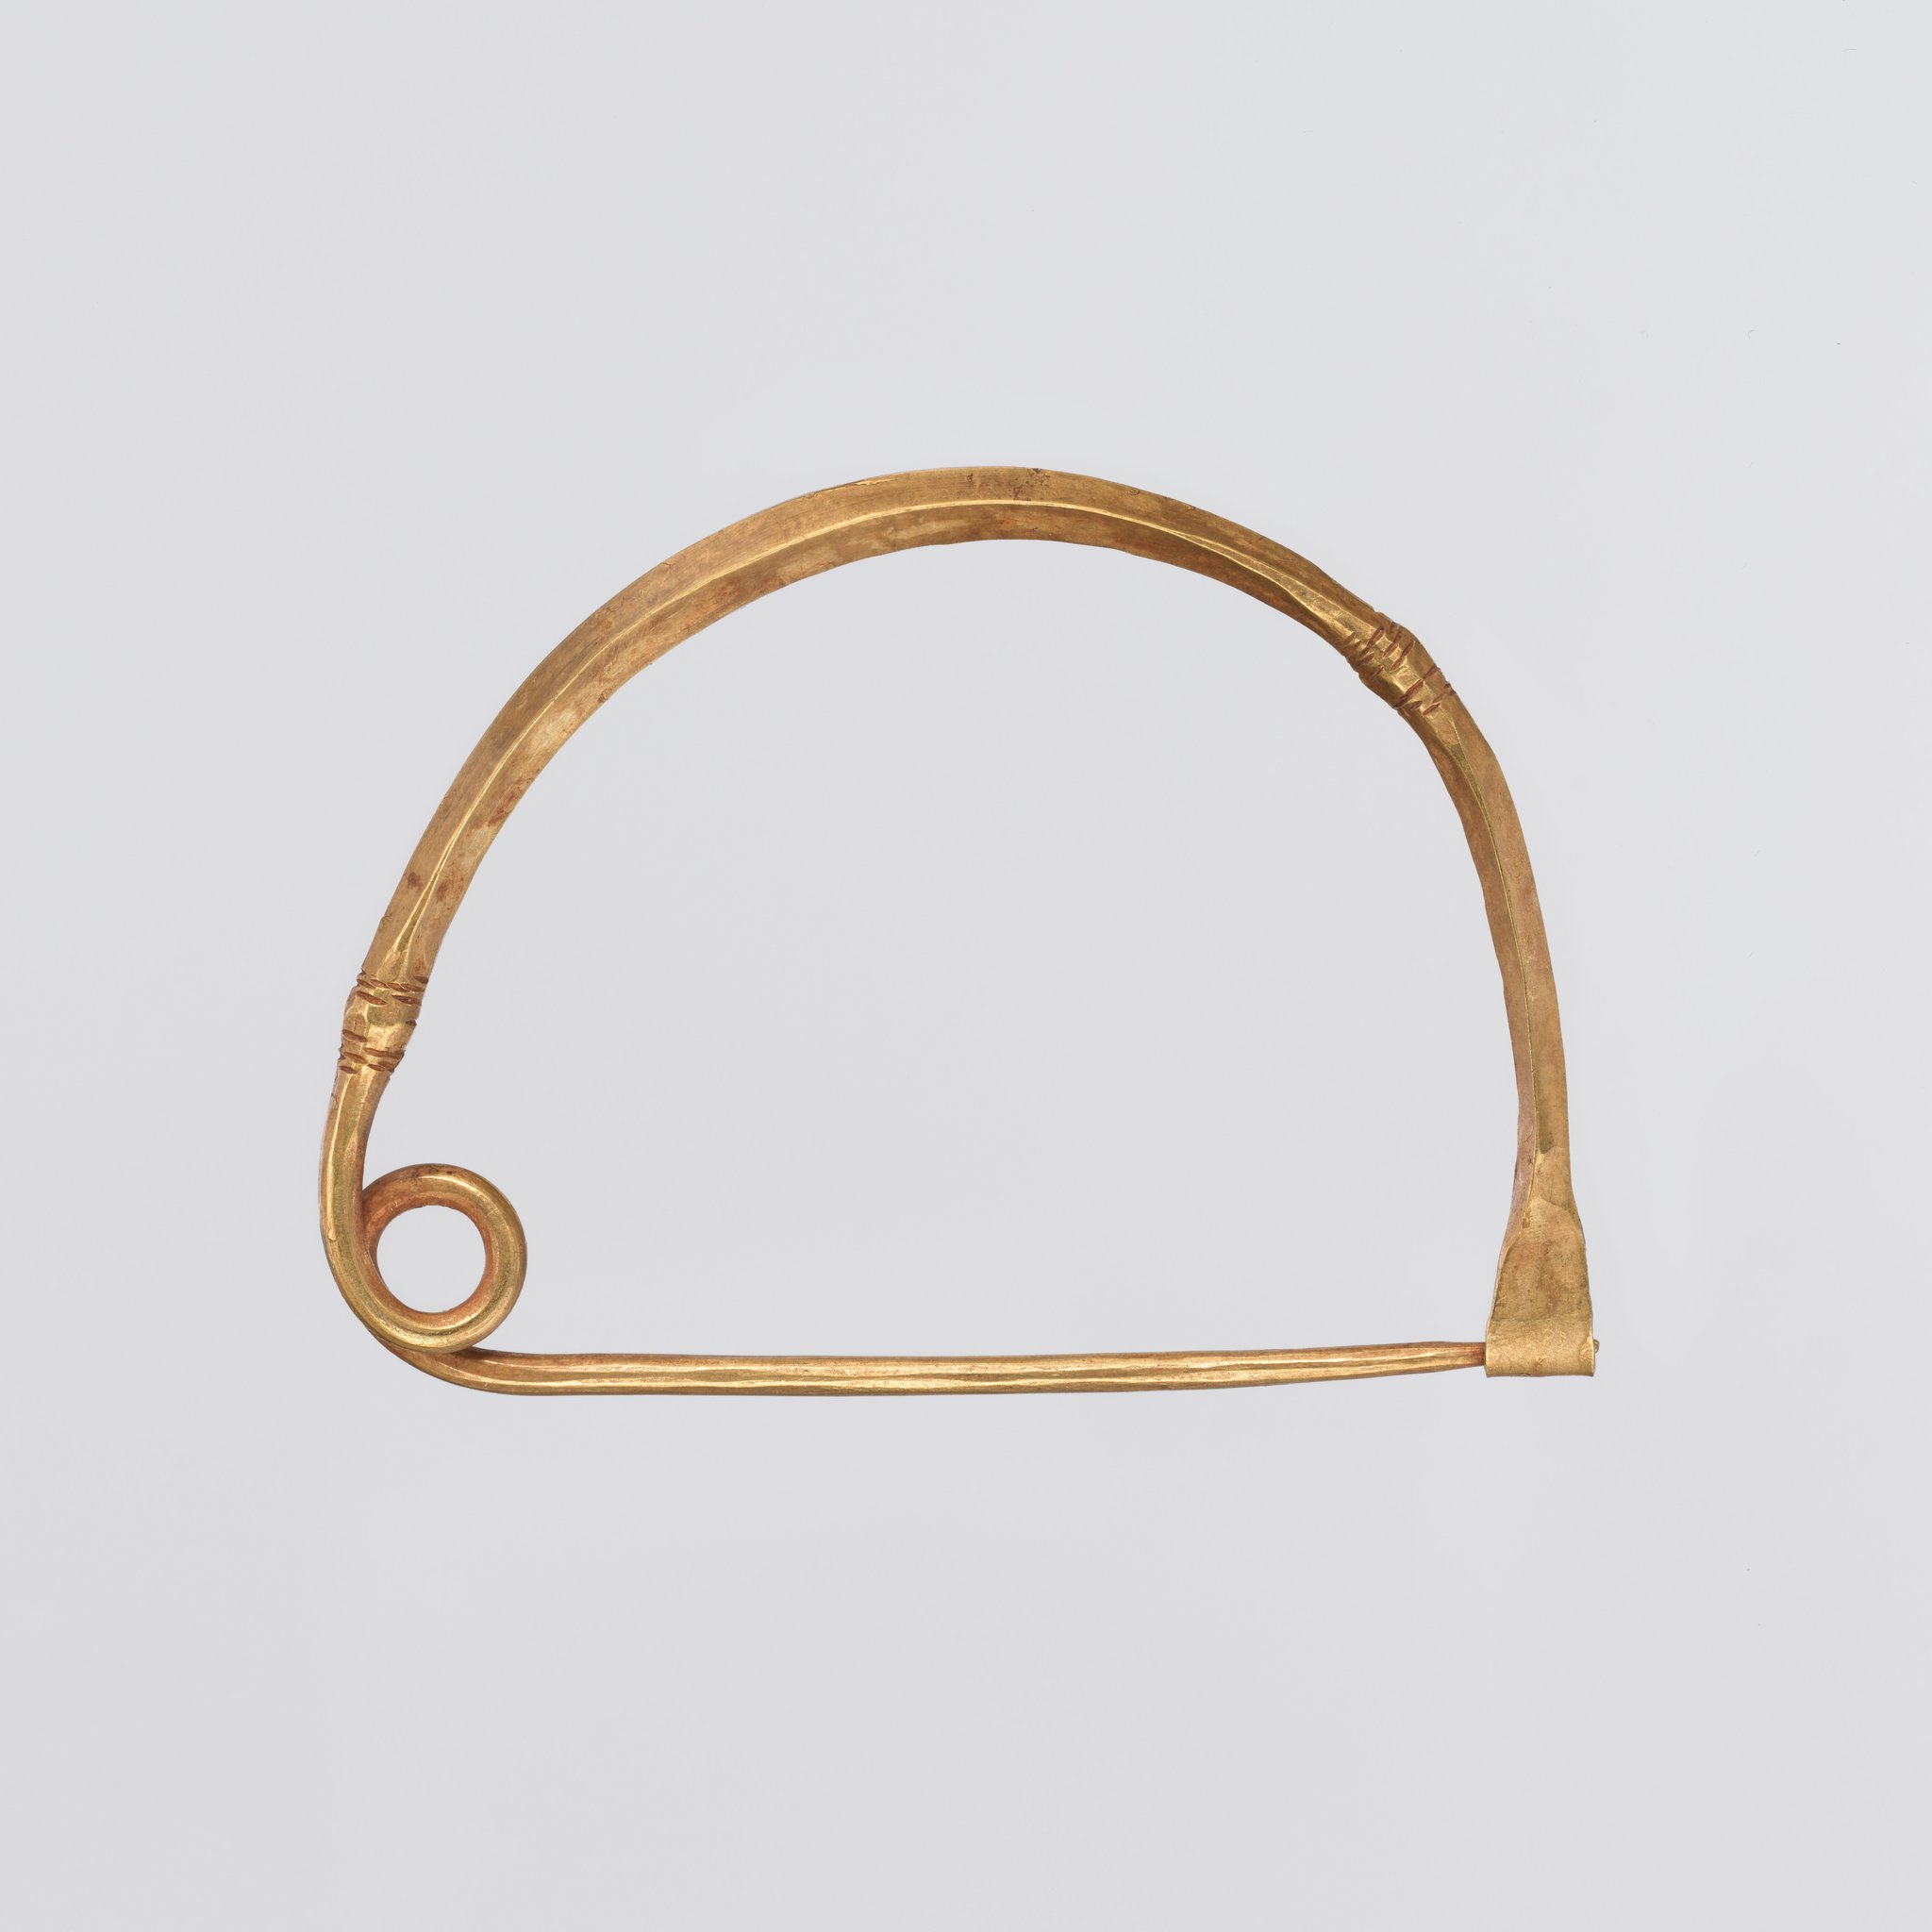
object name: fibula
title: Gold fibula (safety pin)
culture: cypriot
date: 1050-750 BCE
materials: gold